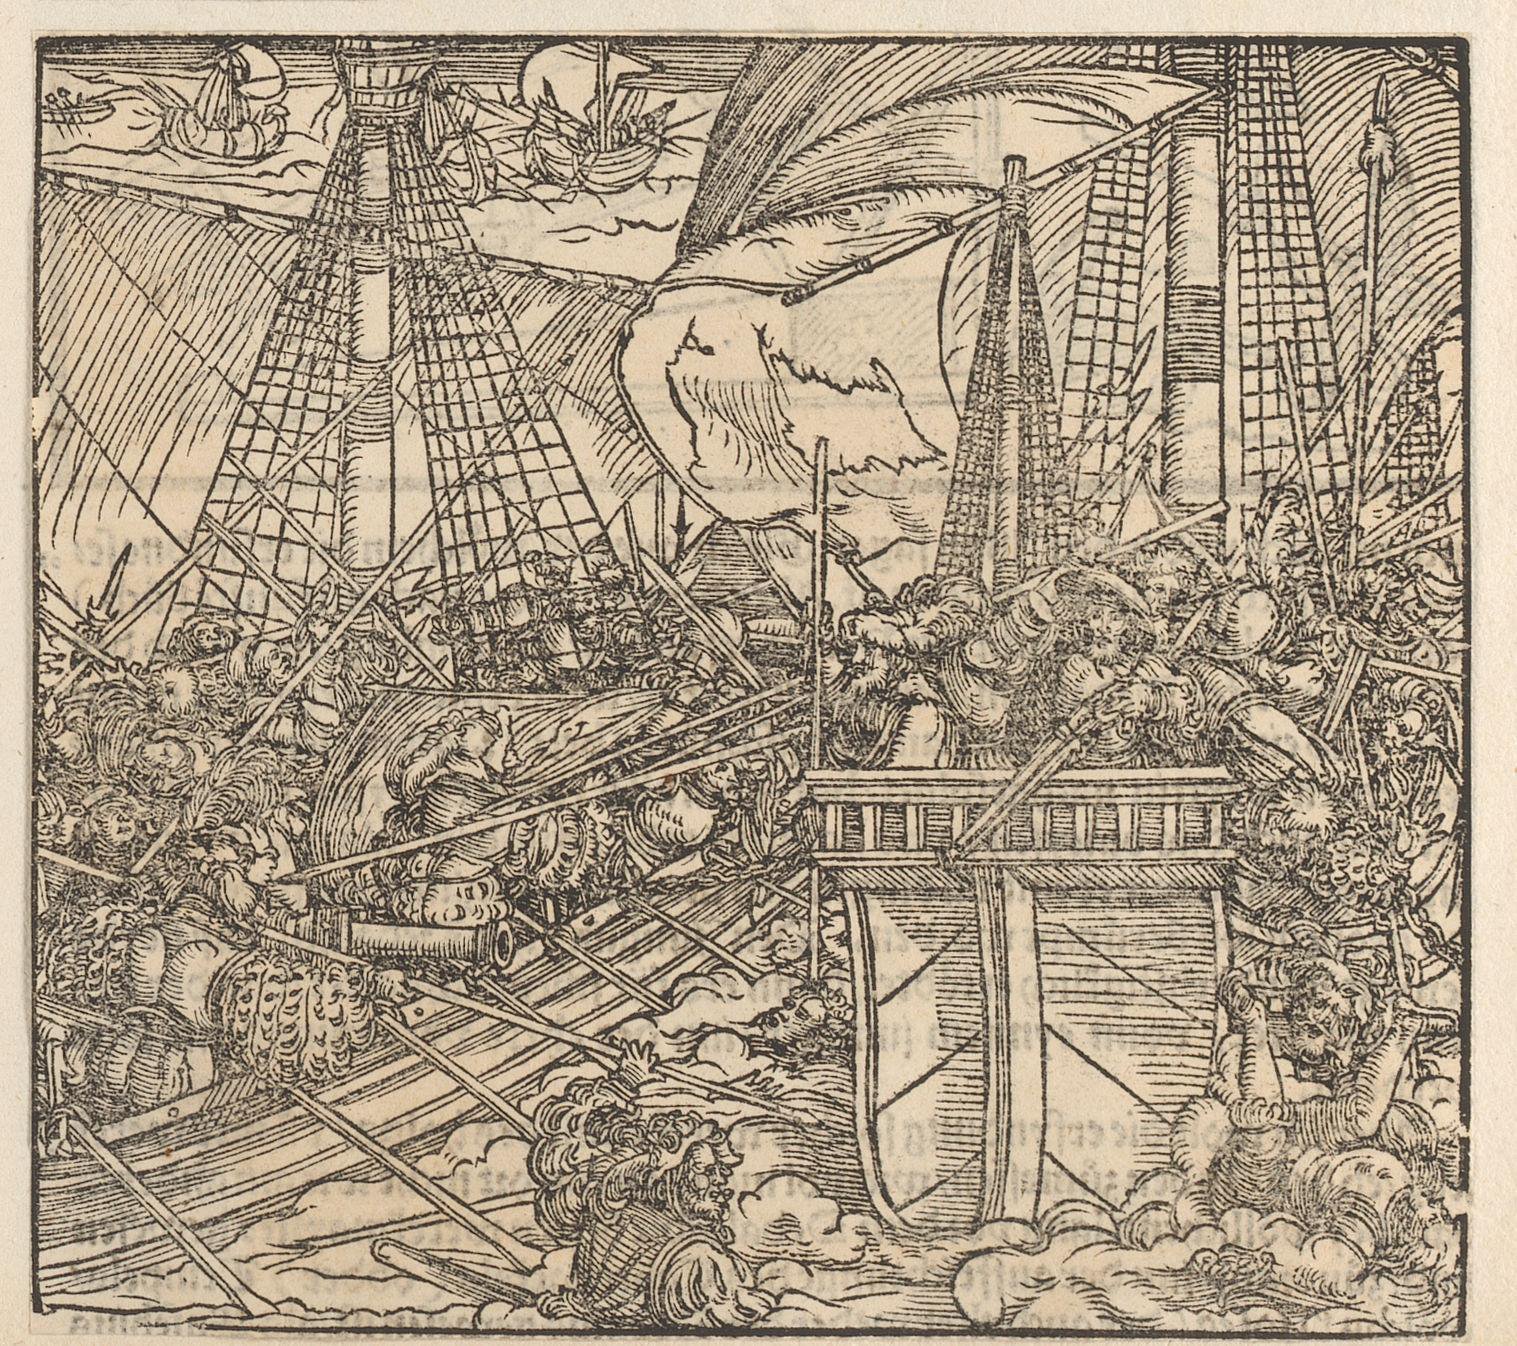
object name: album leaf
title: Zeeslag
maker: Anonymous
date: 1514-1532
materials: paper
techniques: letterpress printing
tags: battle (+ naval force)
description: Deze prent is gebruikt in: Petrarca, Francesco. Von der Artzney bayder Glück, des guten und widerwertigen: unnd weß sich ain yeder inn Gelück und Unglück halten sol (...). Augsburg: Heinrich Steiner, 1532. Deze uitgave is ook bekend onder de titel 'Trostspiegel in Glück und Unglück'.